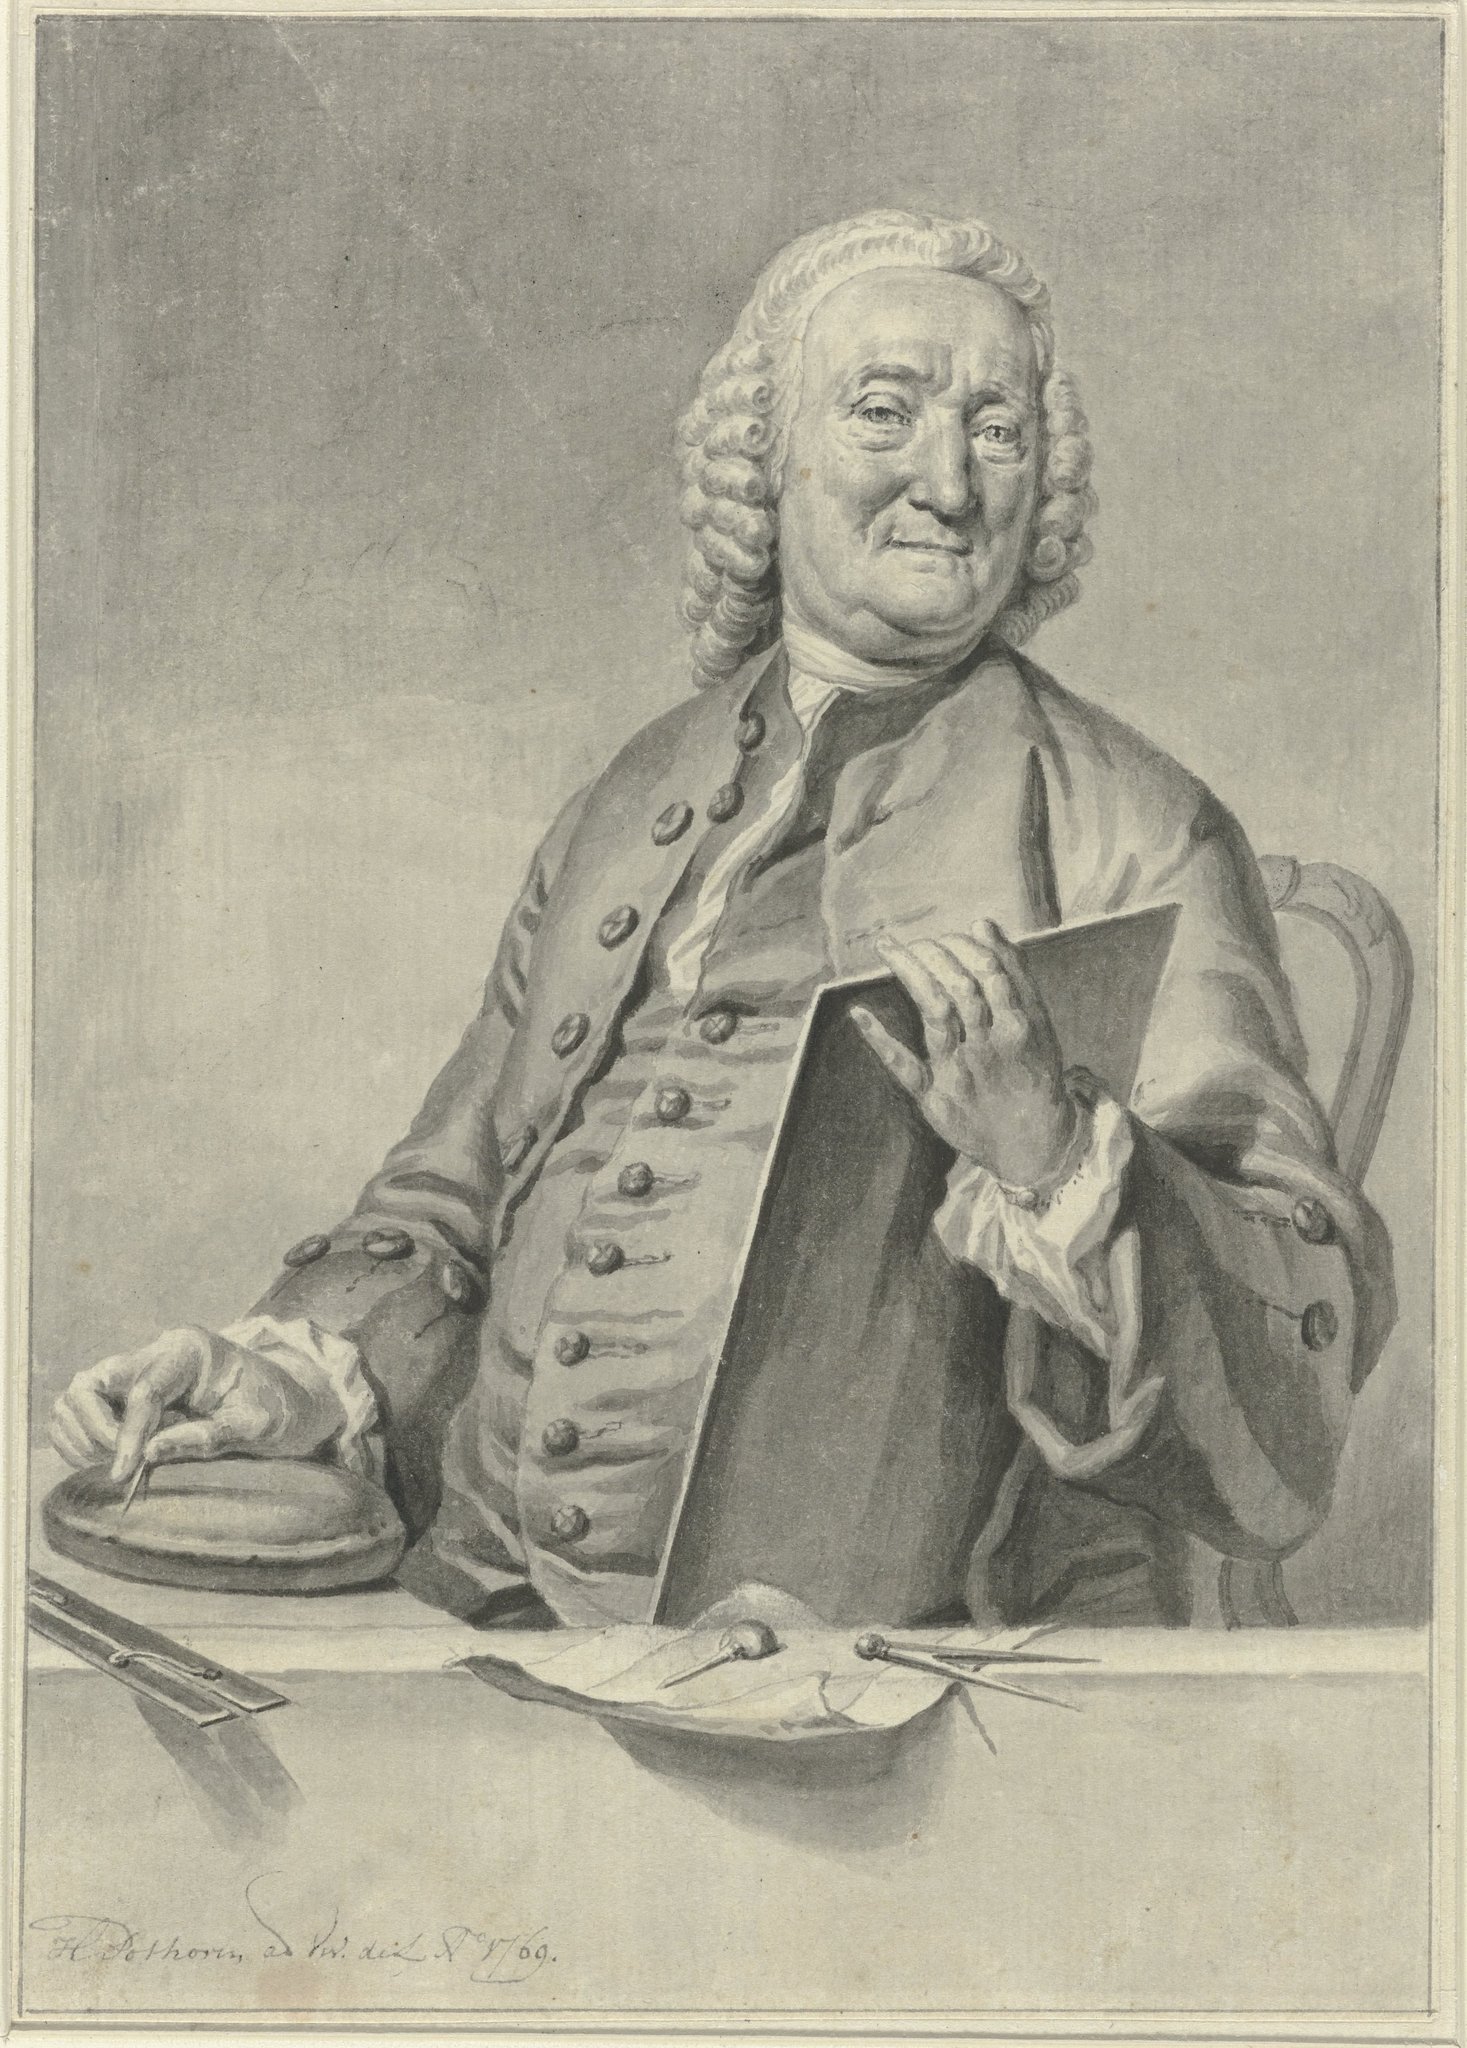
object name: drawing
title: Portret van Jacobus Houbraken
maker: hendrik pothoven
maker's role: draughtsman, painter, print maker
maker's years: 1725-1807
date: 1769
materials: paper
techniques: brush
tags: dordrecht, amsterdam, print maker, draughtsman, jacob houbraken, portrait, self-portrait of painter, portrait, self-portrait of artist, graphic artist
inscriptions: date